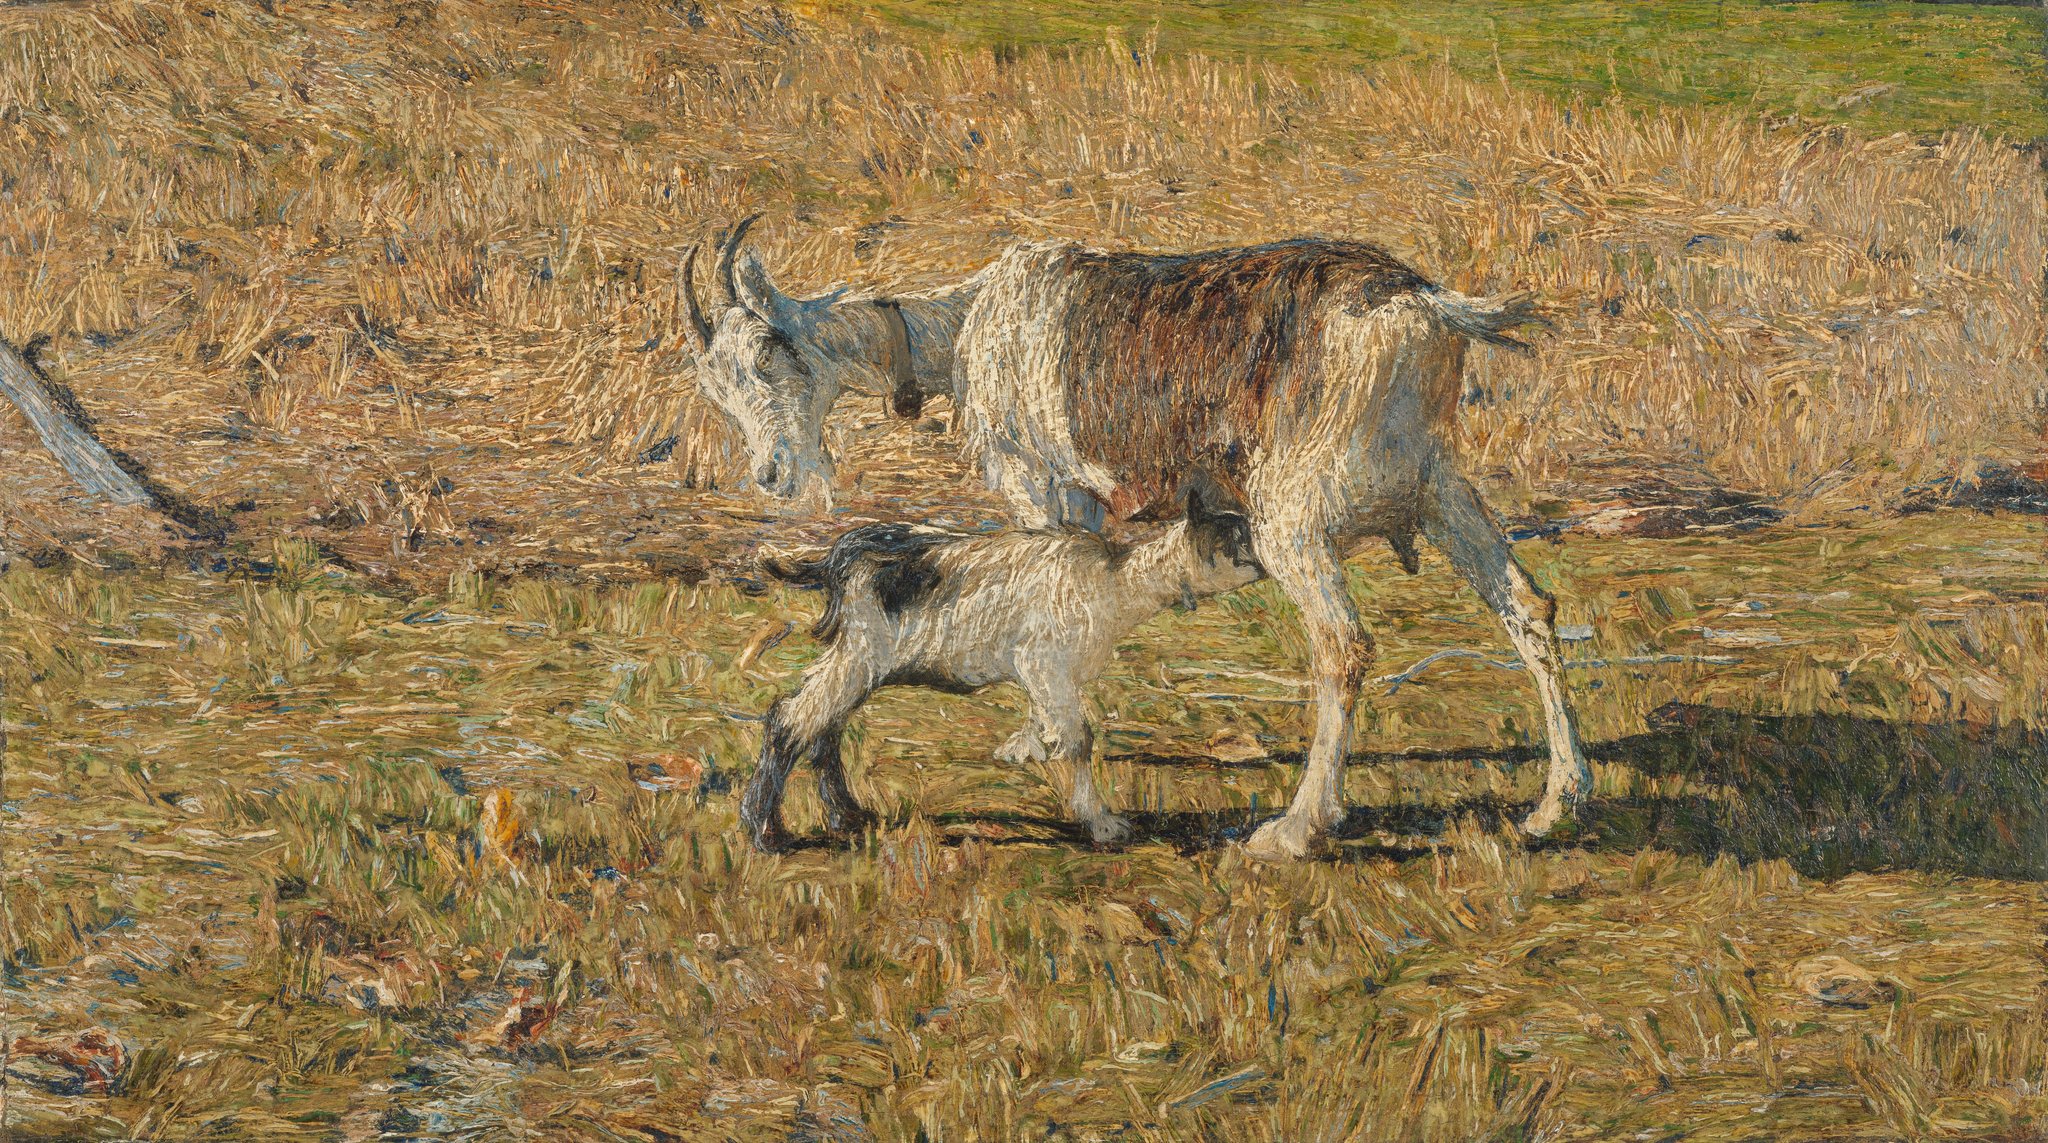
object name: painting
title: A Goat with her Kid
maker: giovanni segantini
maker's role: painter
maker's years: 1858-1899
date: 1890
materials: canvas, oil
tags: she-goat, nanny-goat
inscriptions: signature, date and inscription: ‘G. Segantini, Savognino, 1890, 'Pasqua' Op. LXXXVII’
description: In een grasveld zoogt een geit haar jong.